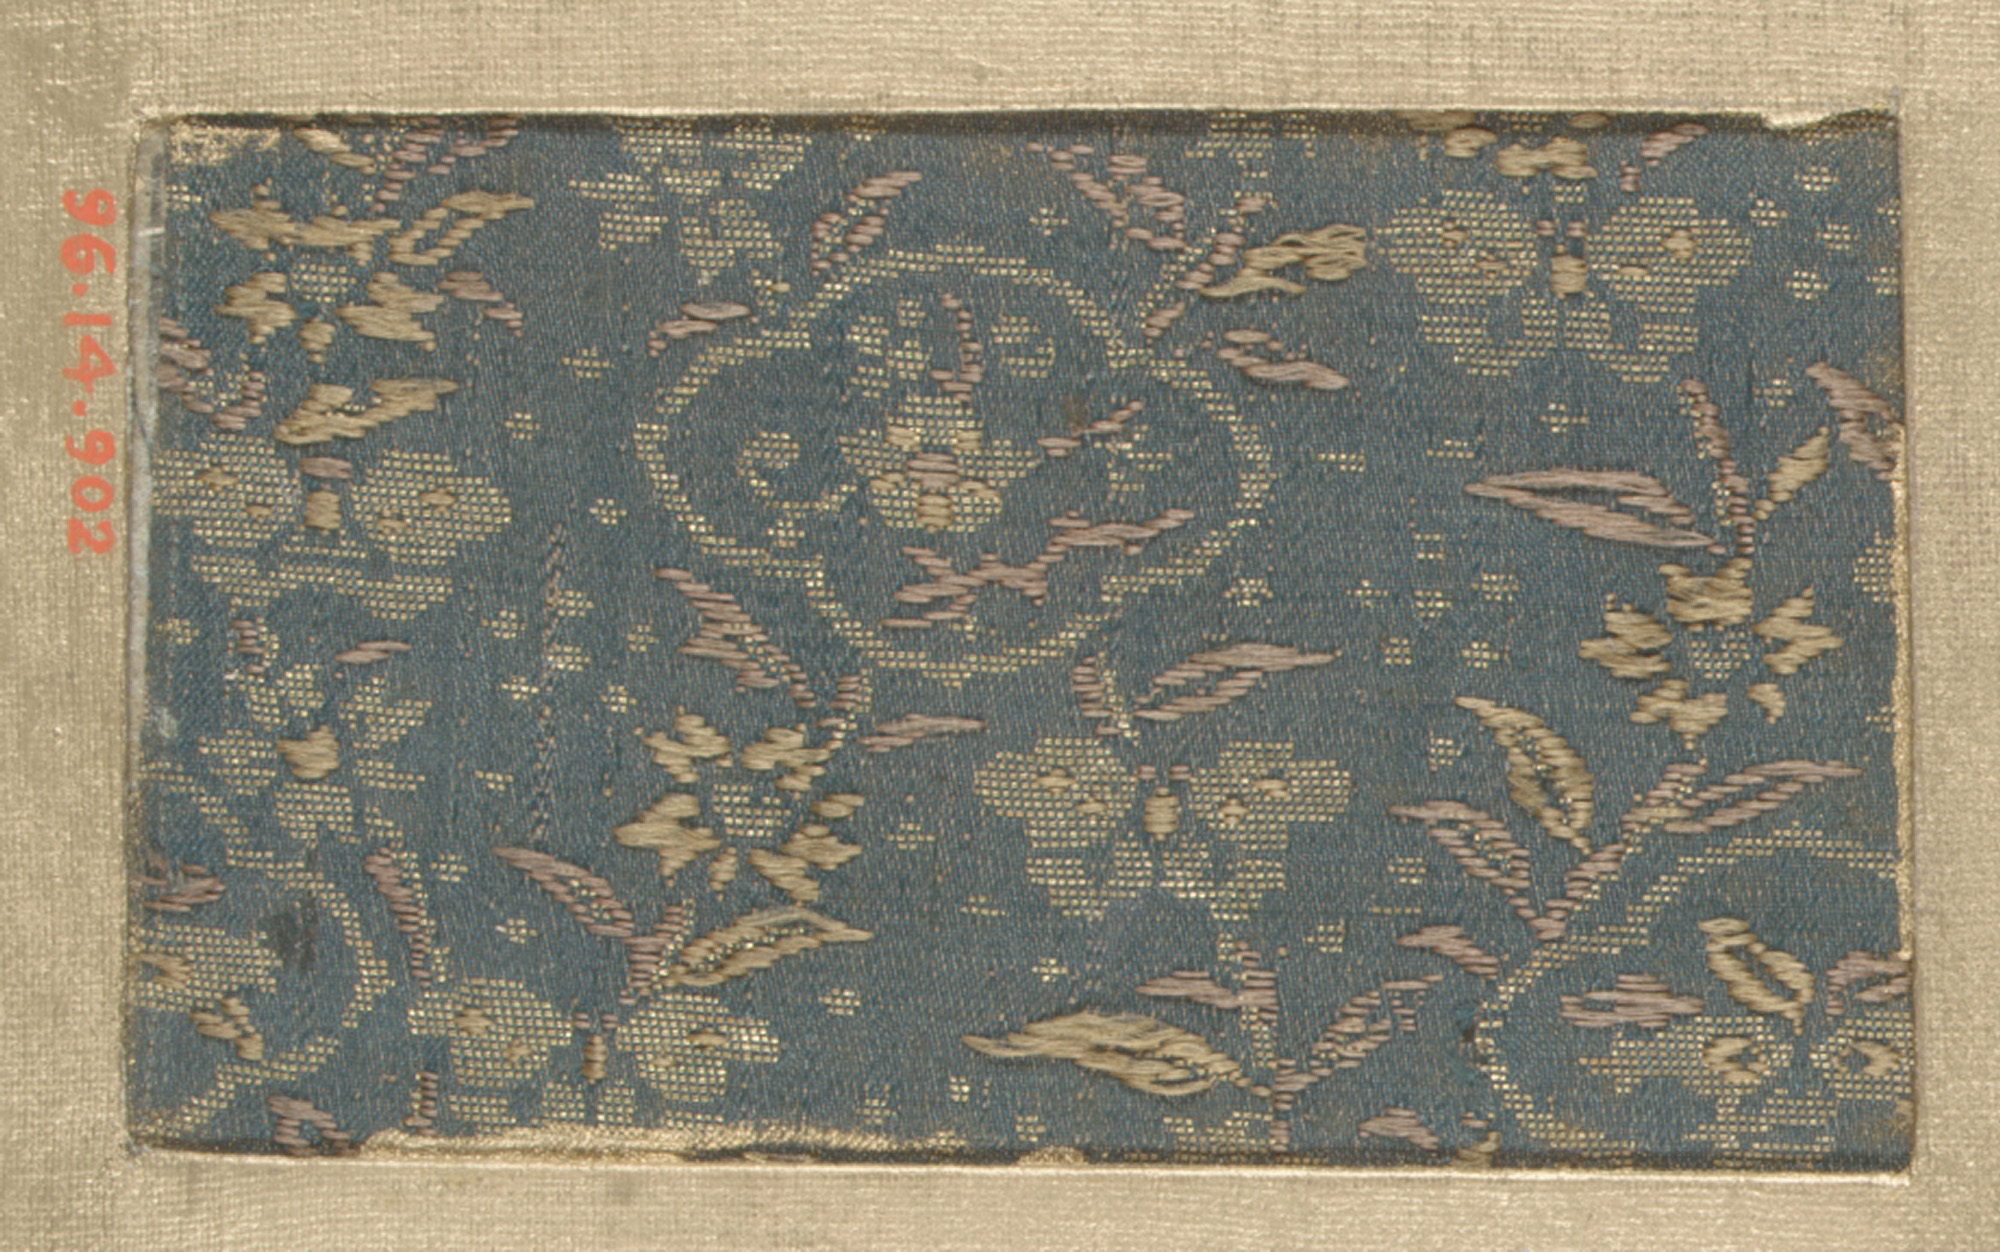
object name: piece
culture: japanese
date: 1701-1900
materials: silk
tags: flowers